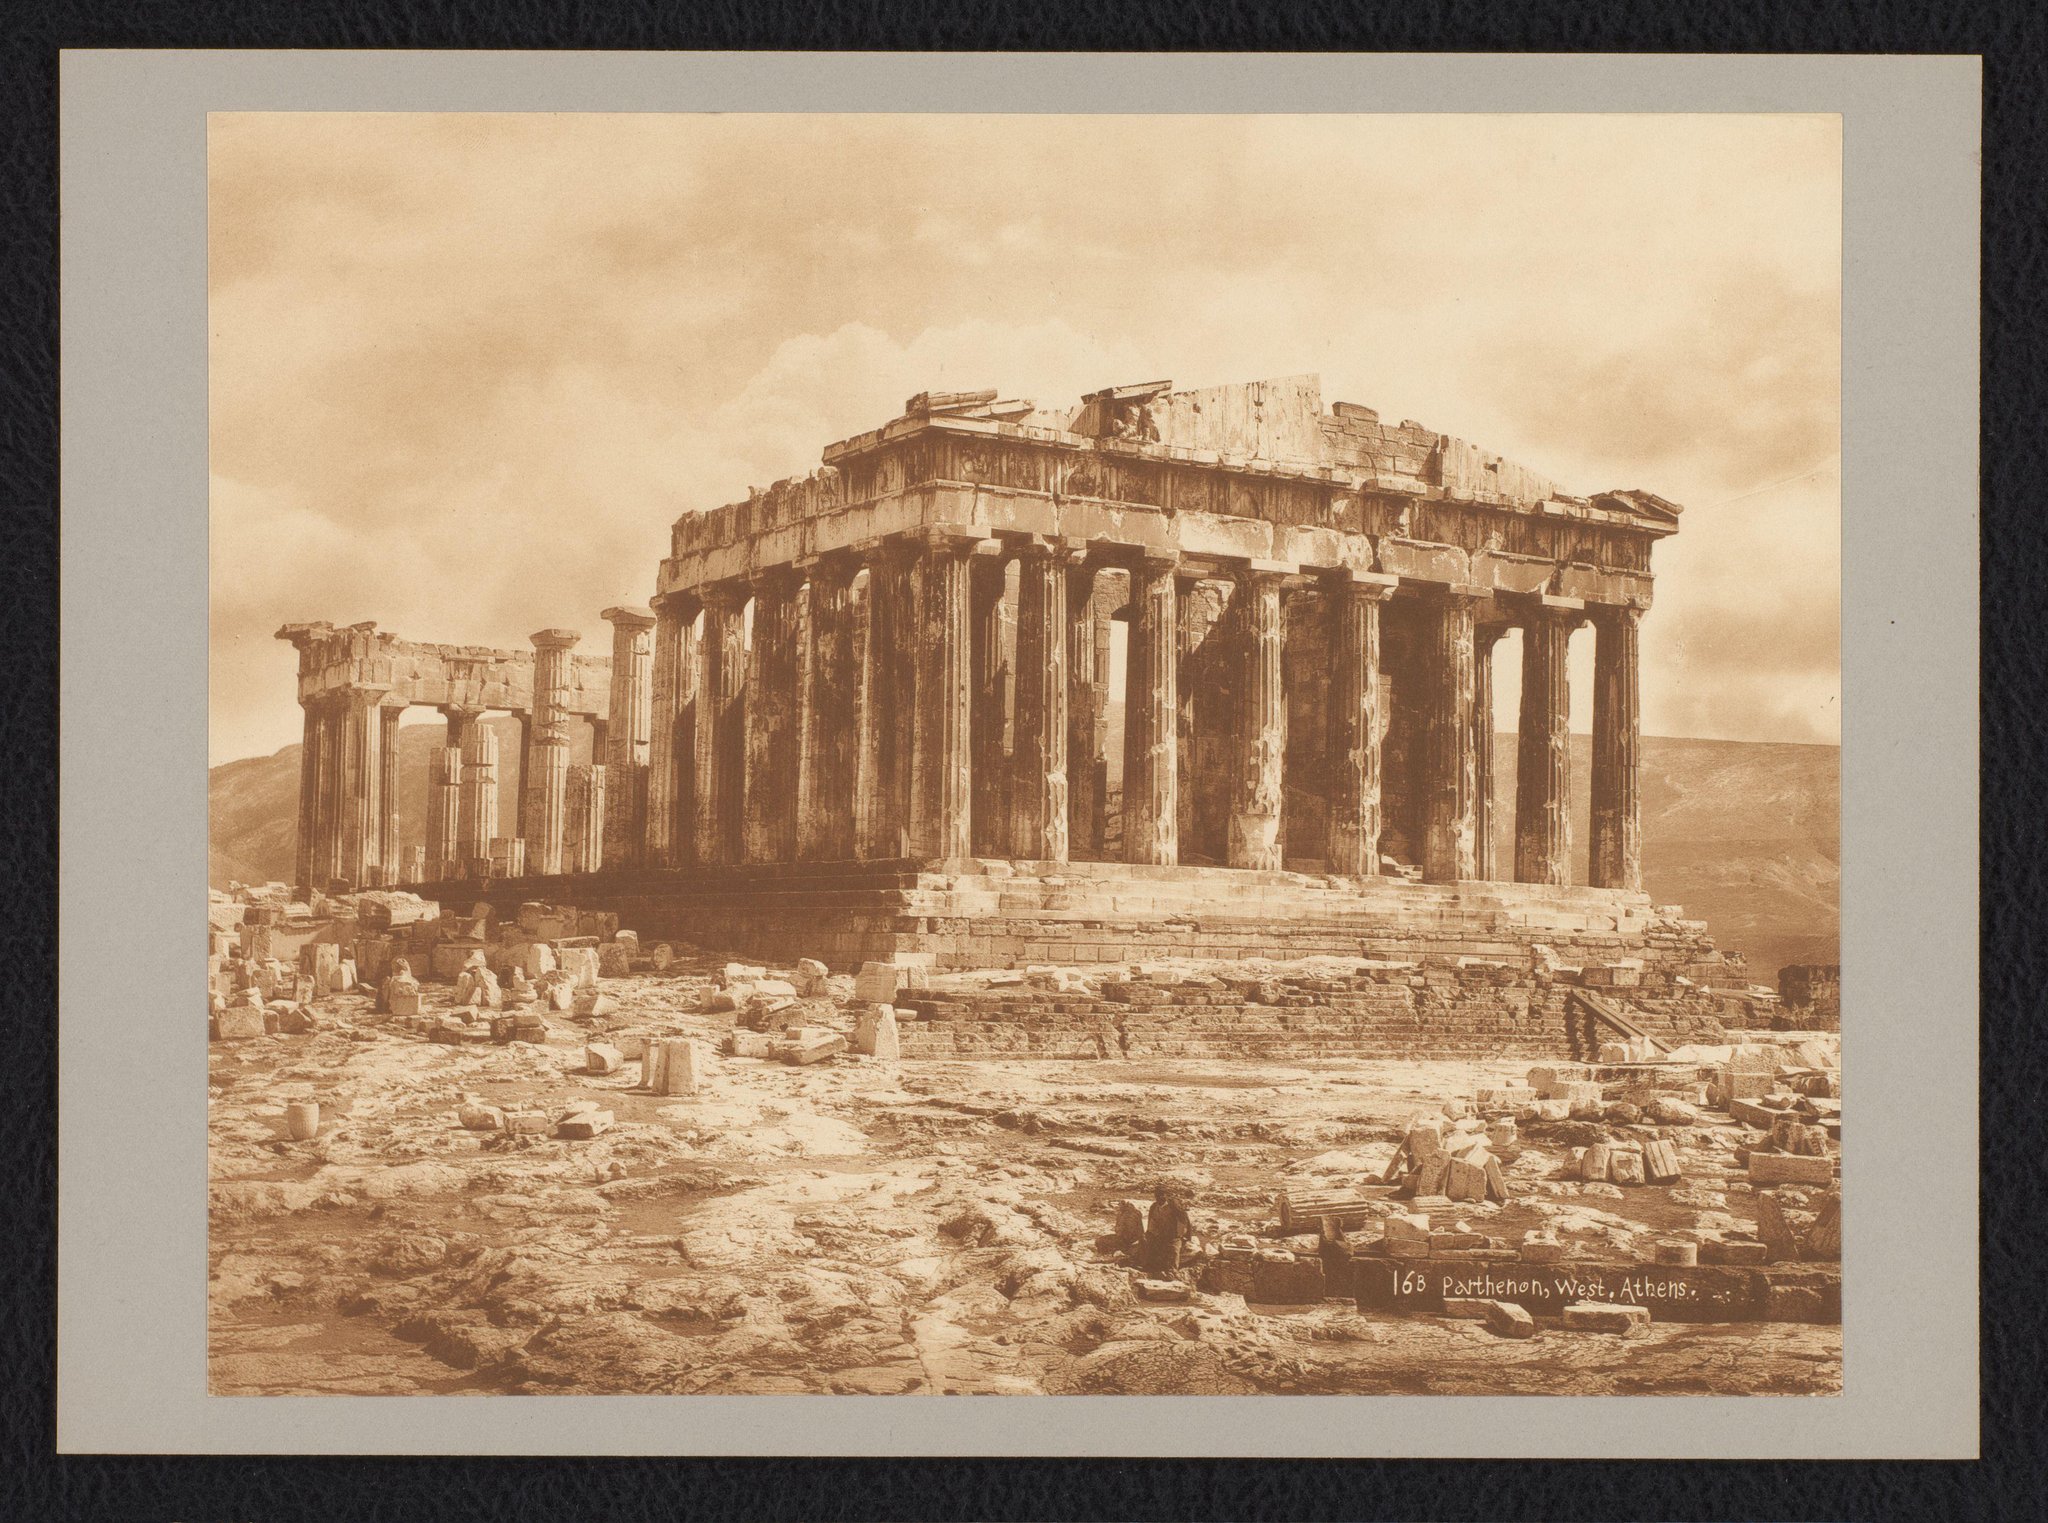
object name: photograph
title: 16B Parthenon, West. Athens.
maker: Anonymous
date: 1895-1915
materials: cardboard, paper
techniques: photograph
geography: athens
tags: athene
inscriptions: number: ‘24.’